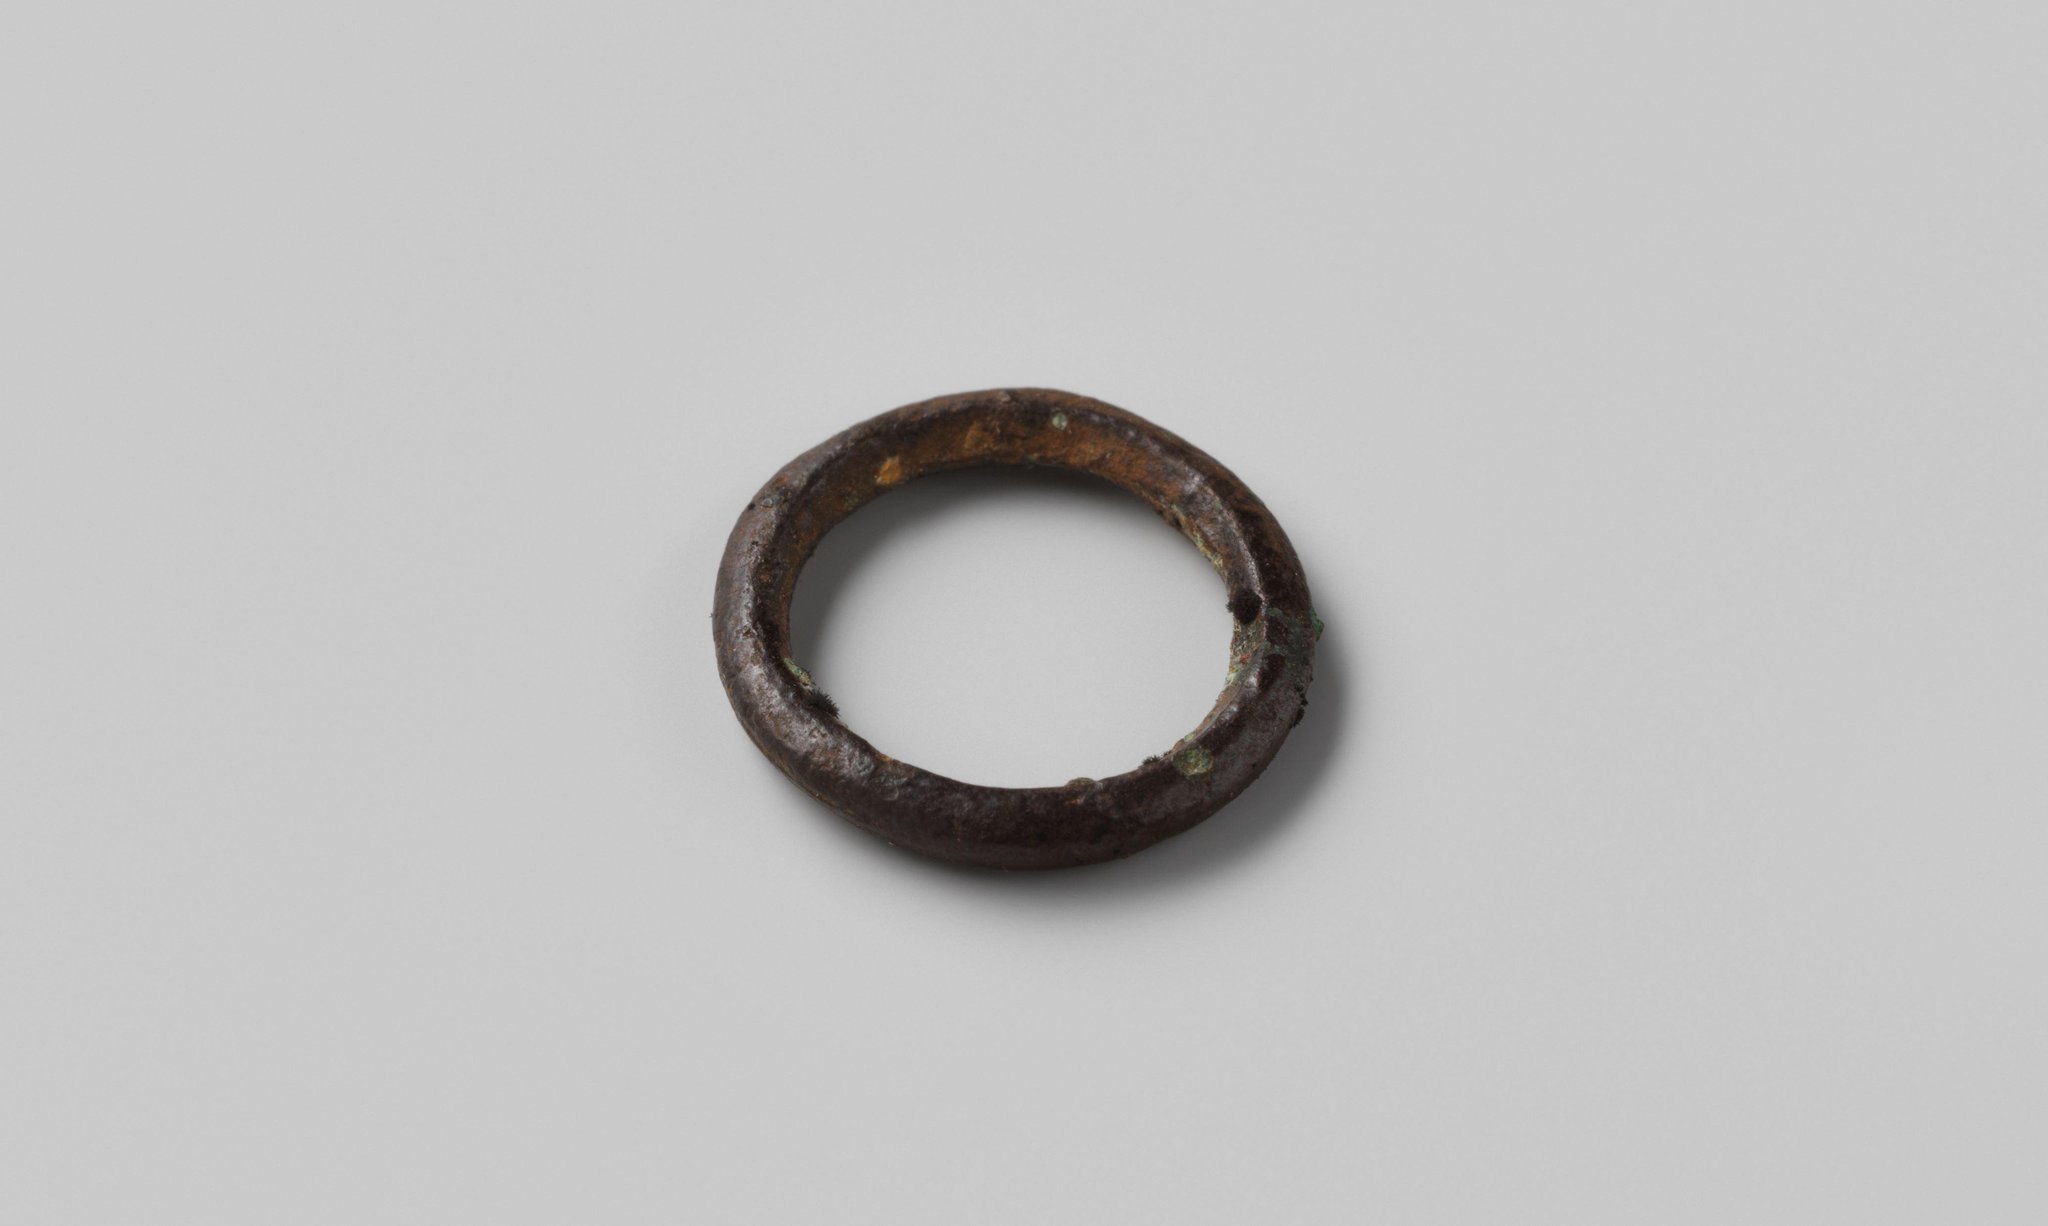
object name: fragment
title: Ringvormig fragment uit het wrak van de Oost-Indiëvaarder Hollandia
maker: Anonymous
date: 1700-1743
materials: copper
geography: netherlands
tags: verenigde oostindische compagnie, hollandia (schip), annet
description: Varied parts or fragments, rings or ring-shaped fragments; circular, circular in section.